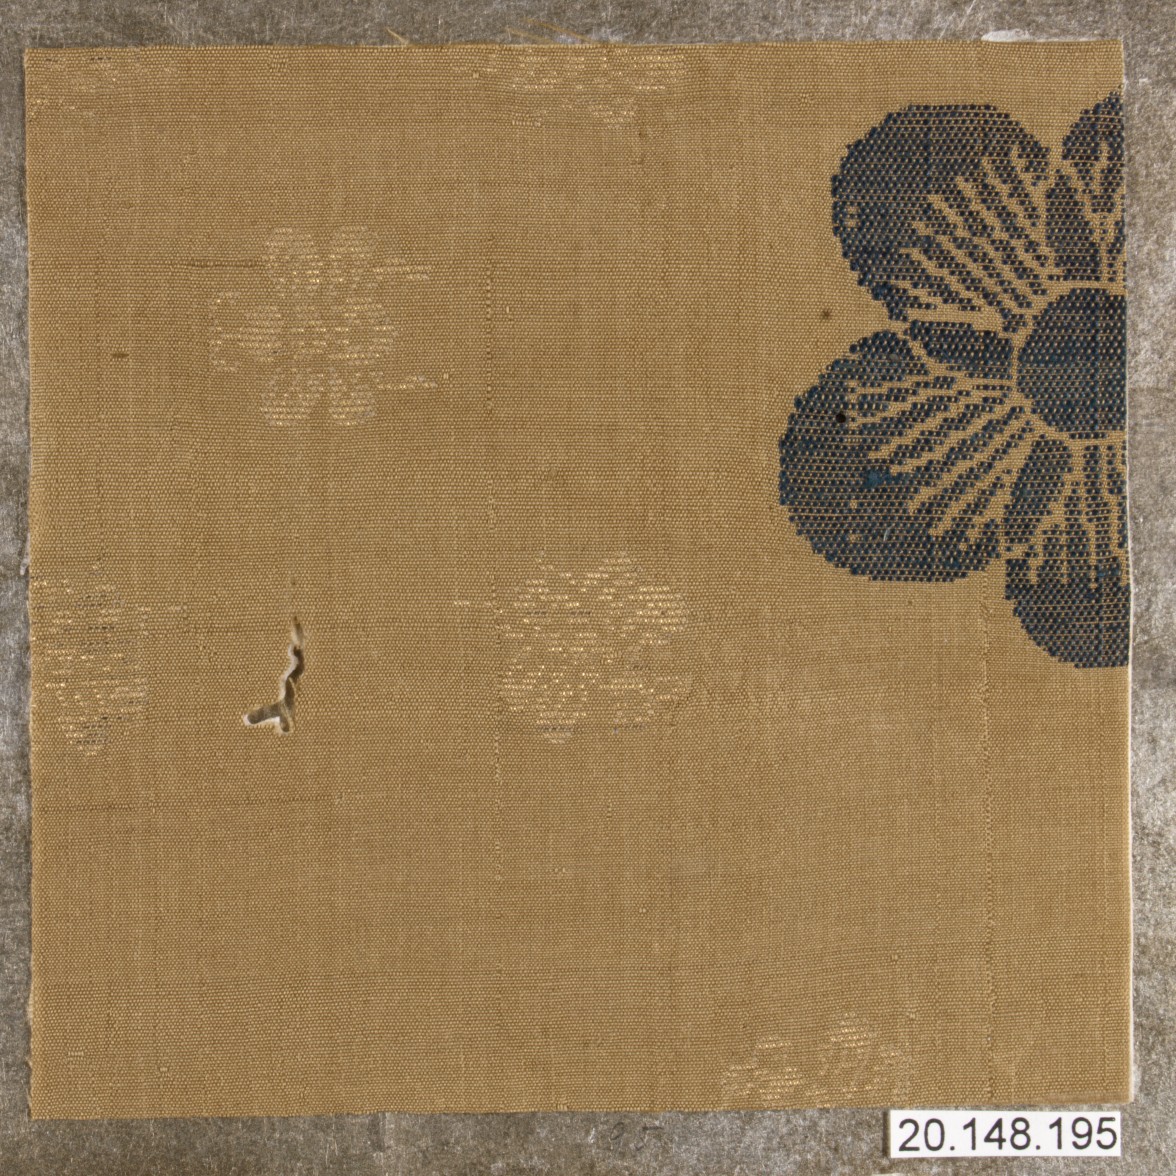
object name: piece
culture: japanese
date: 1701-1800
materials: silk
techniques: compound weave